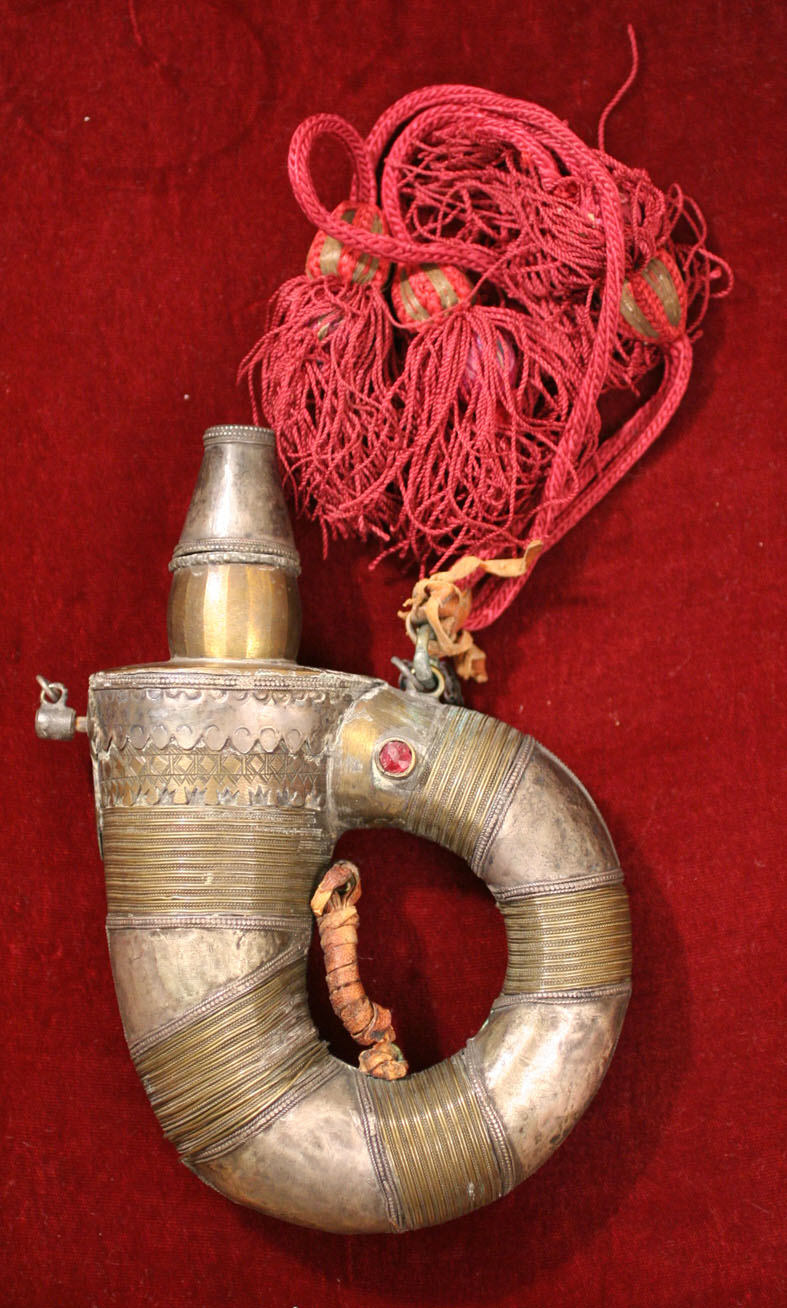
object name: powder horn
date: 1701-1900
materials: brass, silver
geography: saudi arabia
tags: military equipment